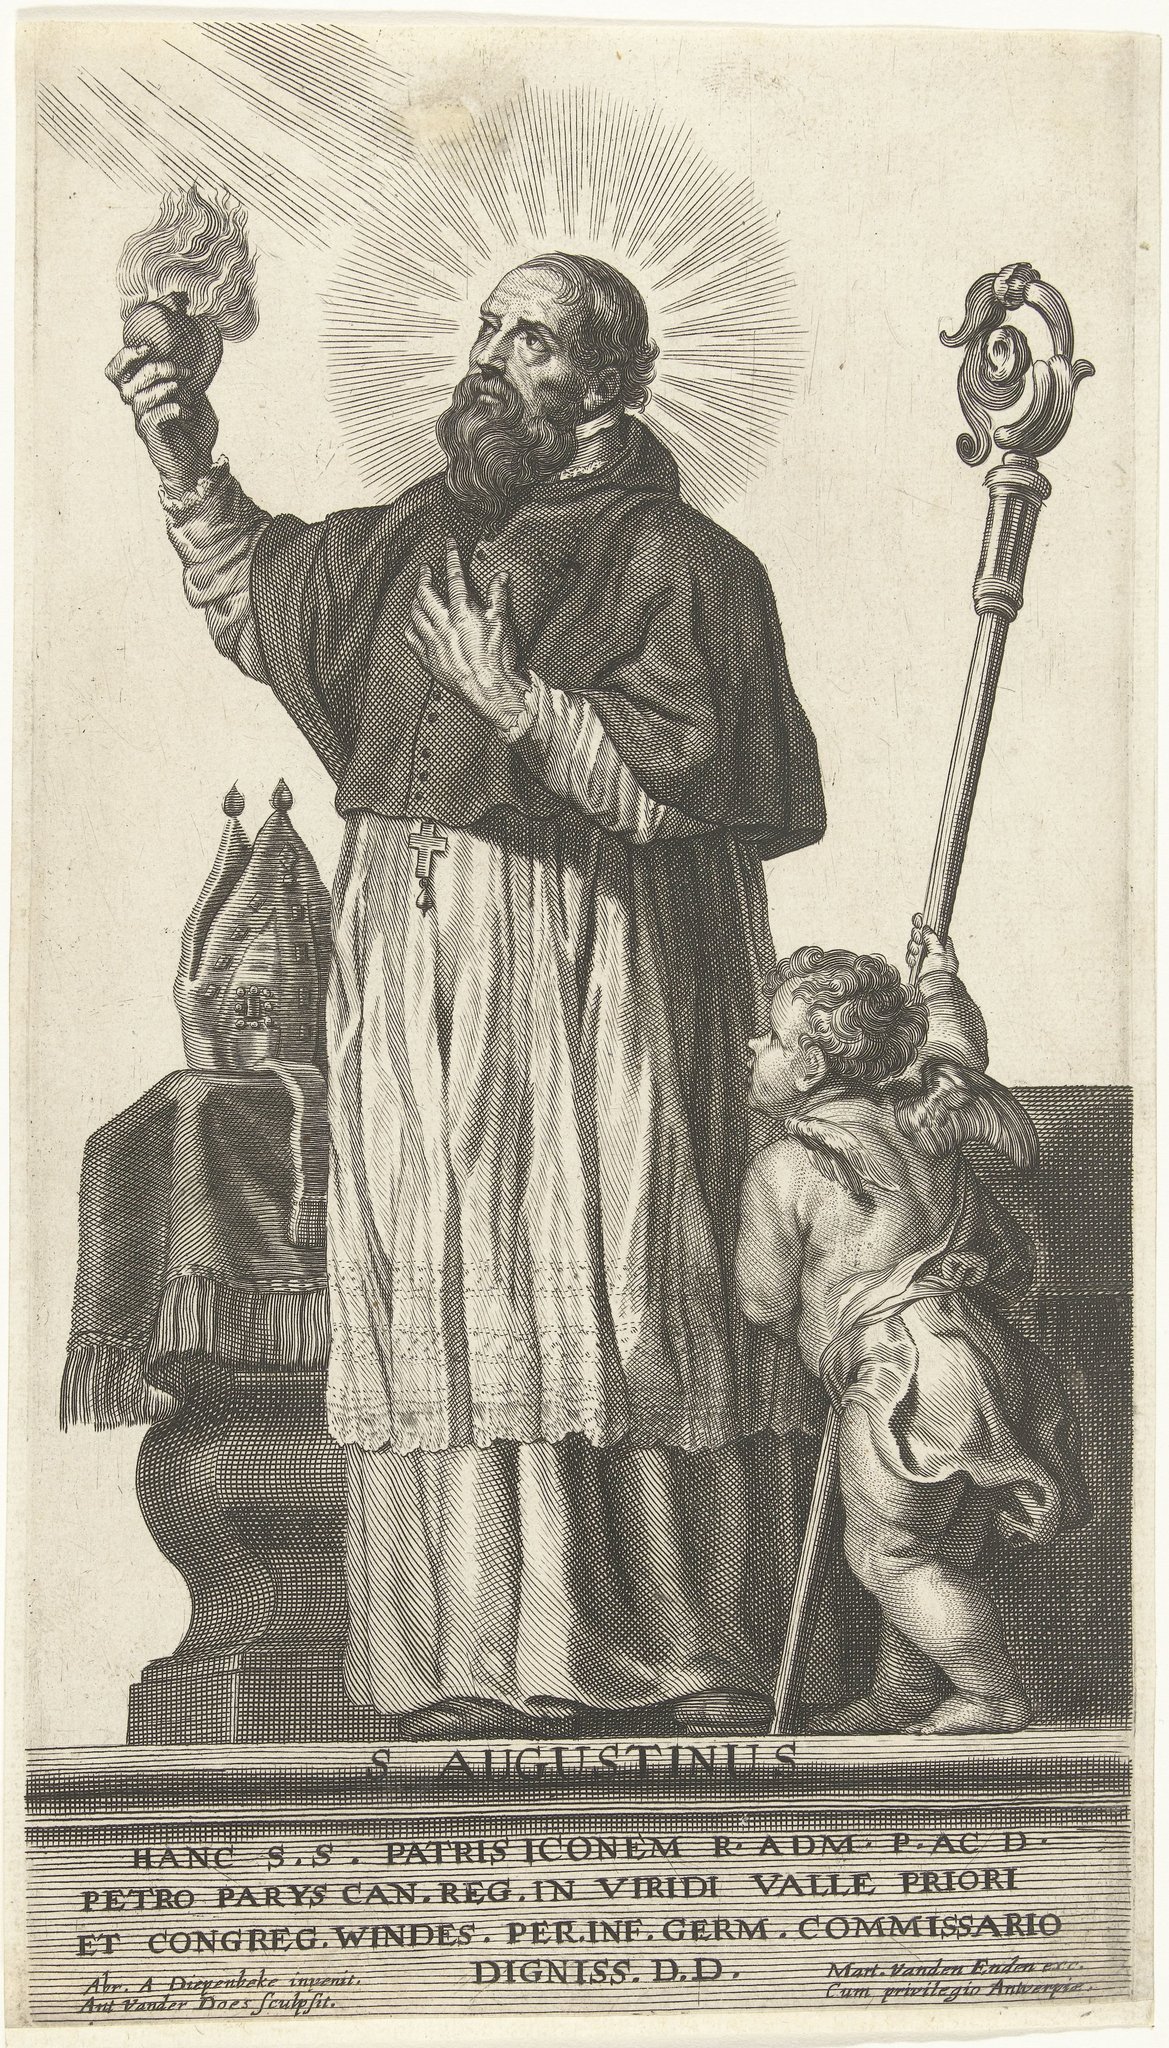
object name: print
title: Heilige Augustinus met brandend hart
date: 1619-1680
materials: paper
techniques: engraving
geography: antwerp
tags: augustine, bishop of hippo; possible attributes: arrows piercing his breast, book, child with spoon, flaming heart, heart (pierced with arrows), pen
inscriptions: collector's mark: Lugt 2228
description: Heilige Augustinus met brandend hart en engel met kromstaf. Onder vier regels Latijnse tekst.